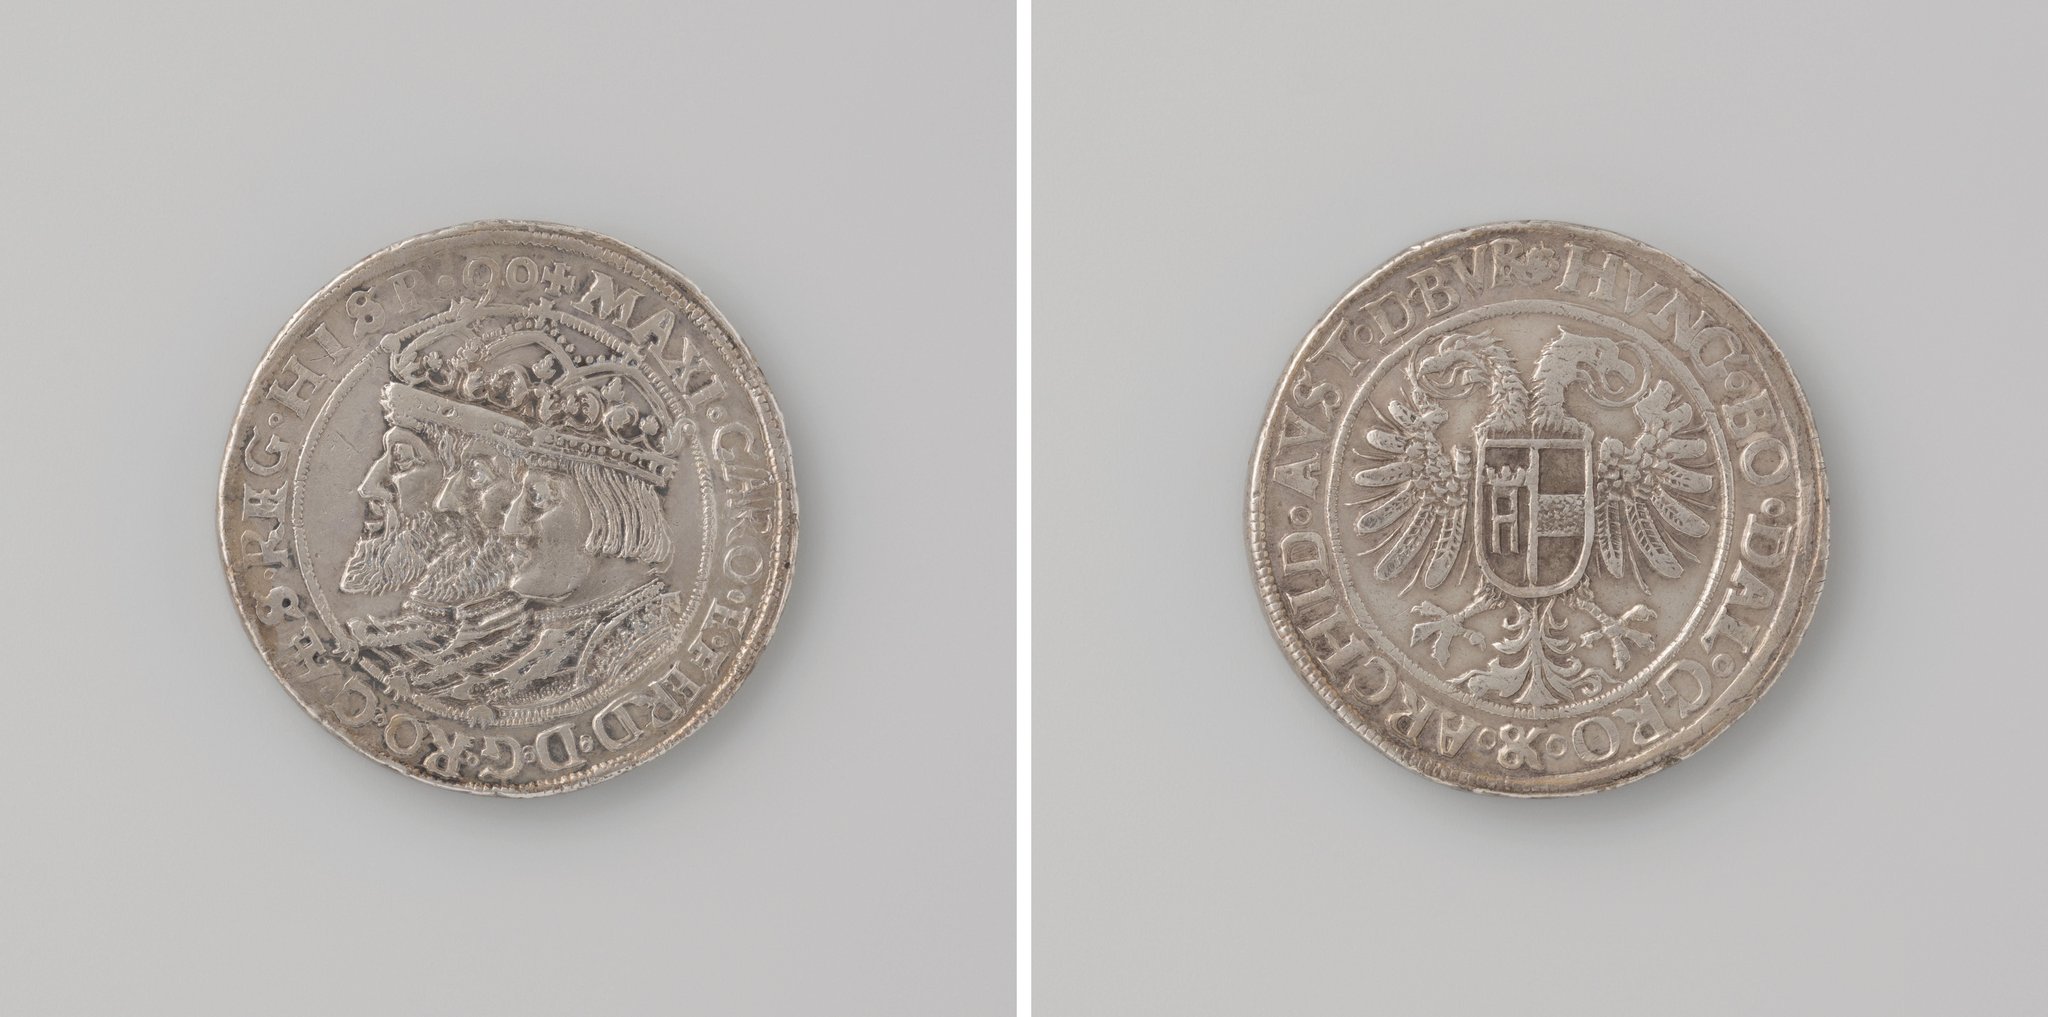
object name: dubbele taler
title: Dubbele taler (dubbele driekeizertaler) uit Bohemen van Rudolf II, met de hoofden van Maximiliaan I, Karel V en Ferdinand I, Duits keizers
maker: Anonymous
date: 1590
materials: silver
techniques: striking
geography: jàchymov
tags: maximilian i (holy roman emperor), charles v (holy roman emperor and king of spain), ferdinand i van habsburg (duits keizer), vienna, prague, rudolf ii van habsburg (duits keizer)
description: Voorzijde: borststuk van drie mannen met kroon binnen omschrift. Keerzijde: dubbelkoppige adelaar met wapenschild binnen omschrift